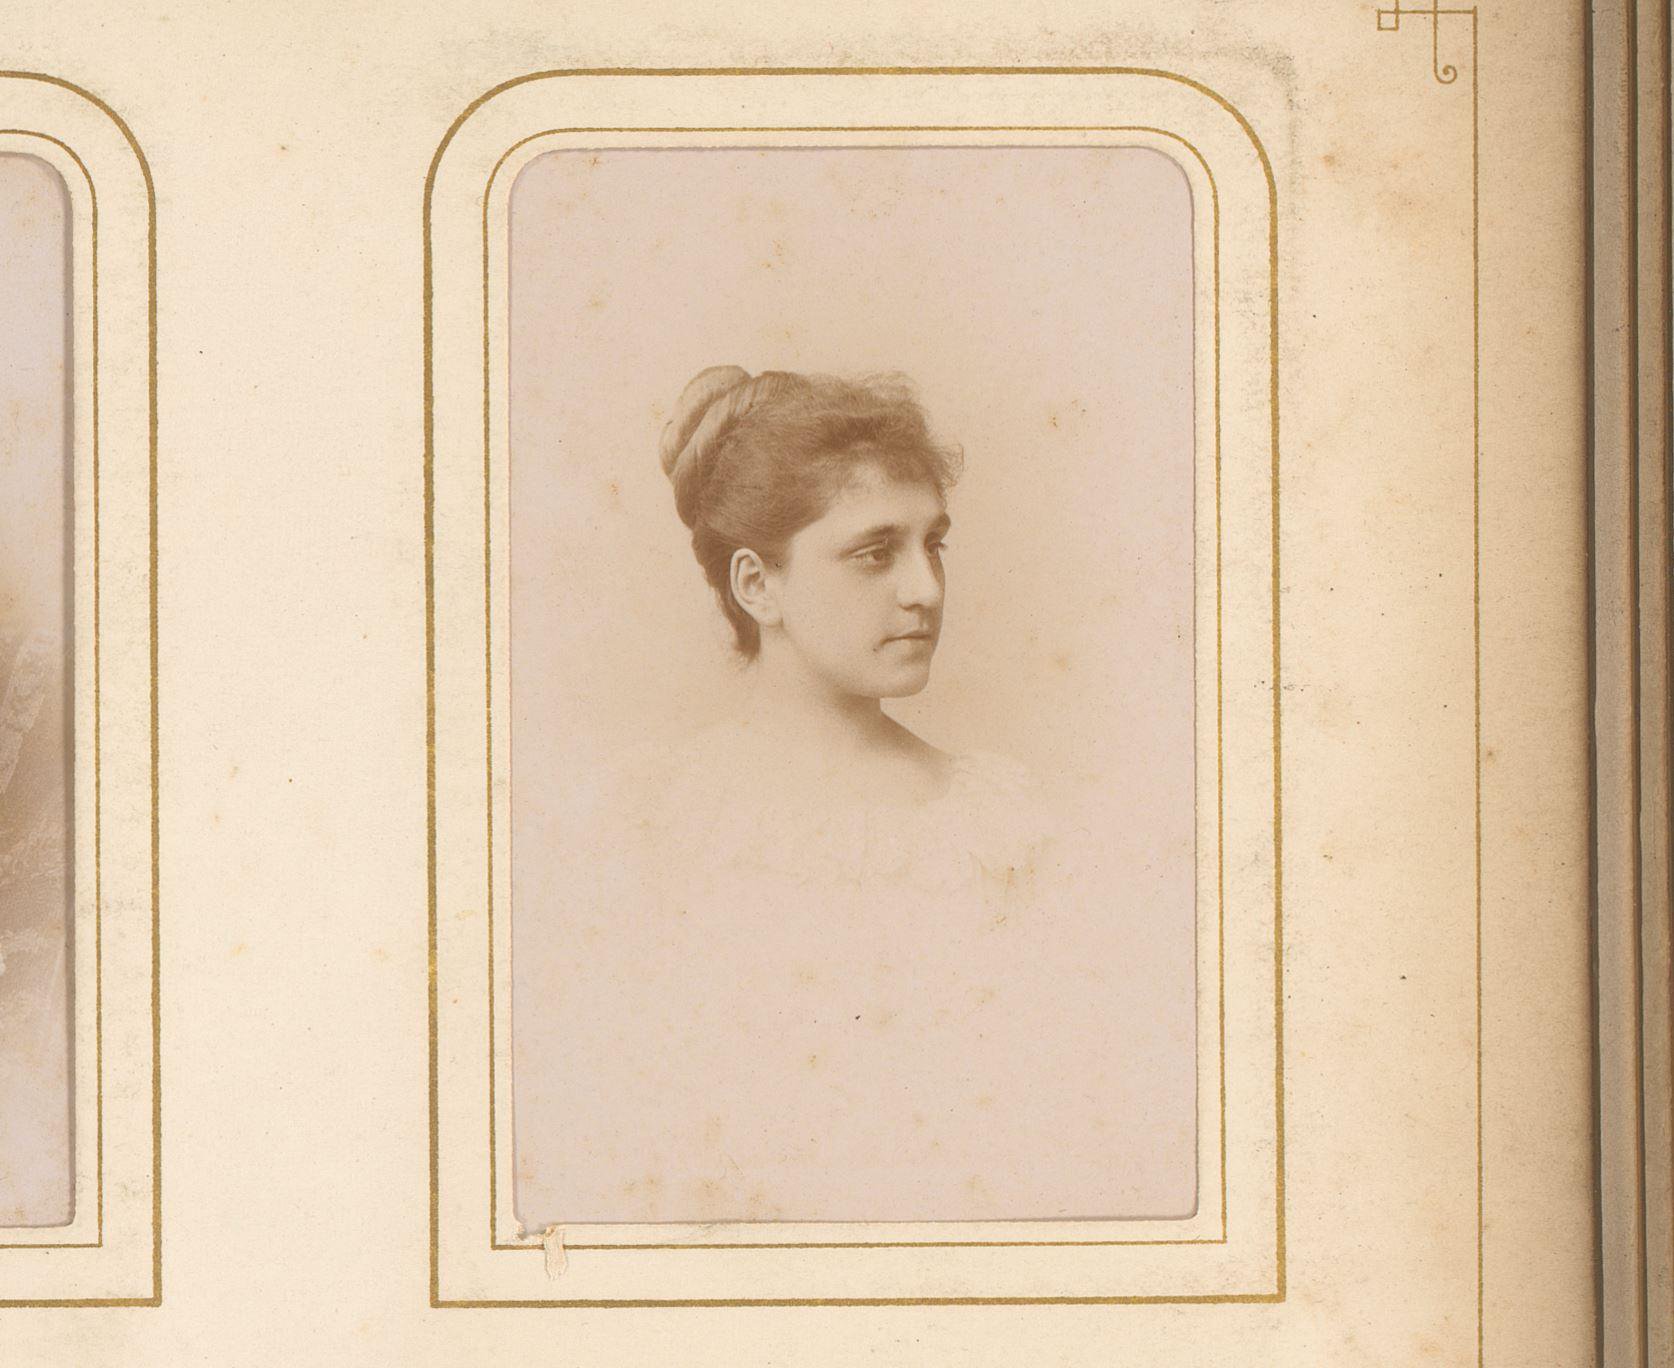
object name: album leaf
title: Portret van een jonge vrouw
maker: jean günther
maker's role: fotograaf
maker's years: 1860-1920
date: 1891-1914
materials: cardboard, photographic support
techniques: collodion silver print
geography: brussels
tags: adolescent, young woman, maiden, historical persons - bb - woman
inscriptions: inscription: ‘(...)/ Günther/ 33/ Rue Neuve/ Bruxelles.’